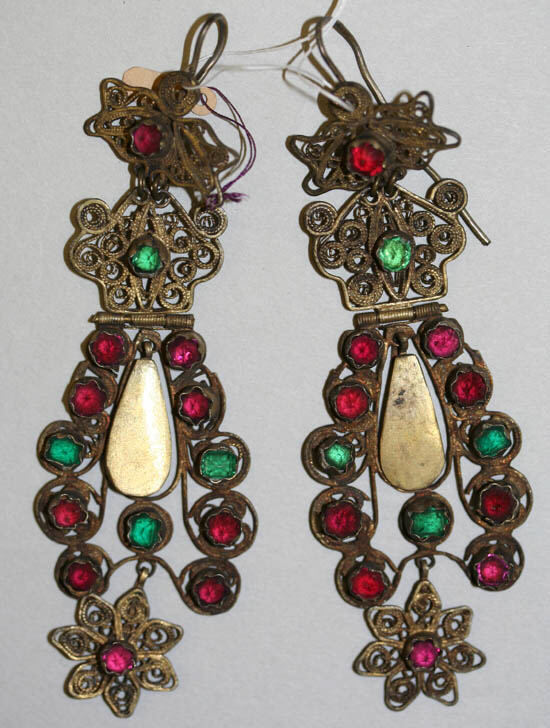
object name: earring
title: Earrings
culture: european, eastern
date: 1701-1900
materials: metal